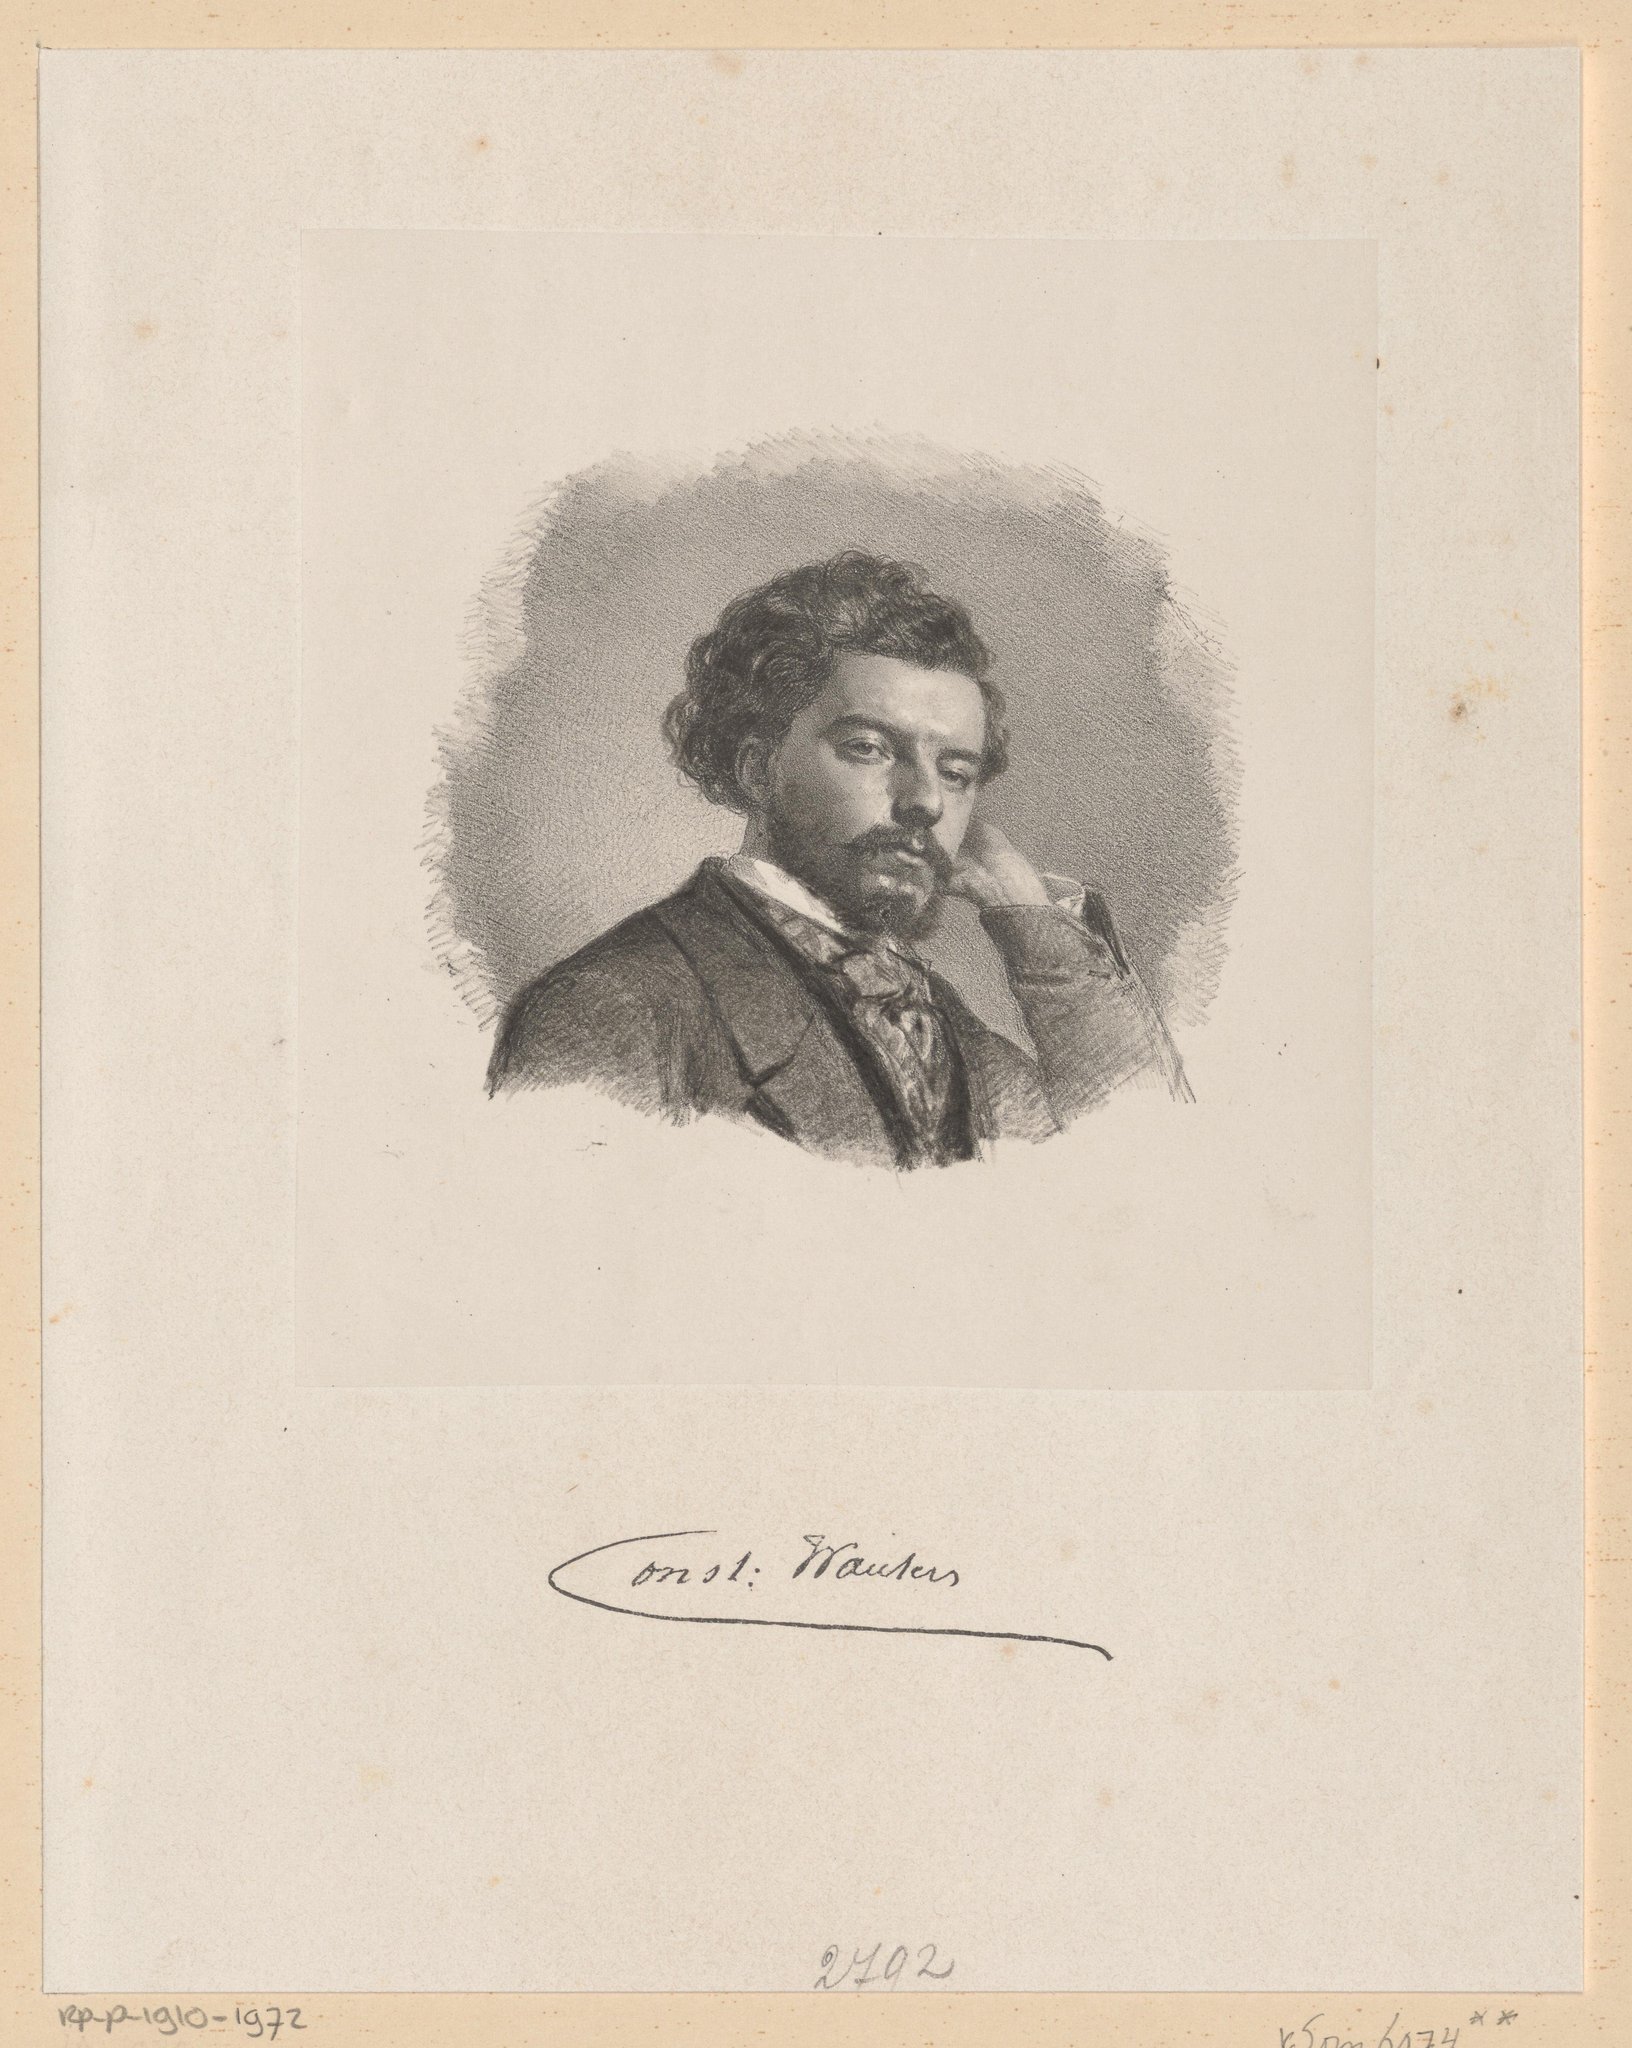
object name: print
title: Portret van Constant Wauters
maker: pieter wilhelmus van de weijer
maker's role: print maker, printer, publisher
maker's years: 1816-1880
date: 1846-1880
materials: paper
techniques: lithograph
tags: antwerp, naples, painter, constant wauters, historical persons, portrait, self-portrait of painter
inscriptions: number: ‘2792’, collector's mark: Lugt 2228